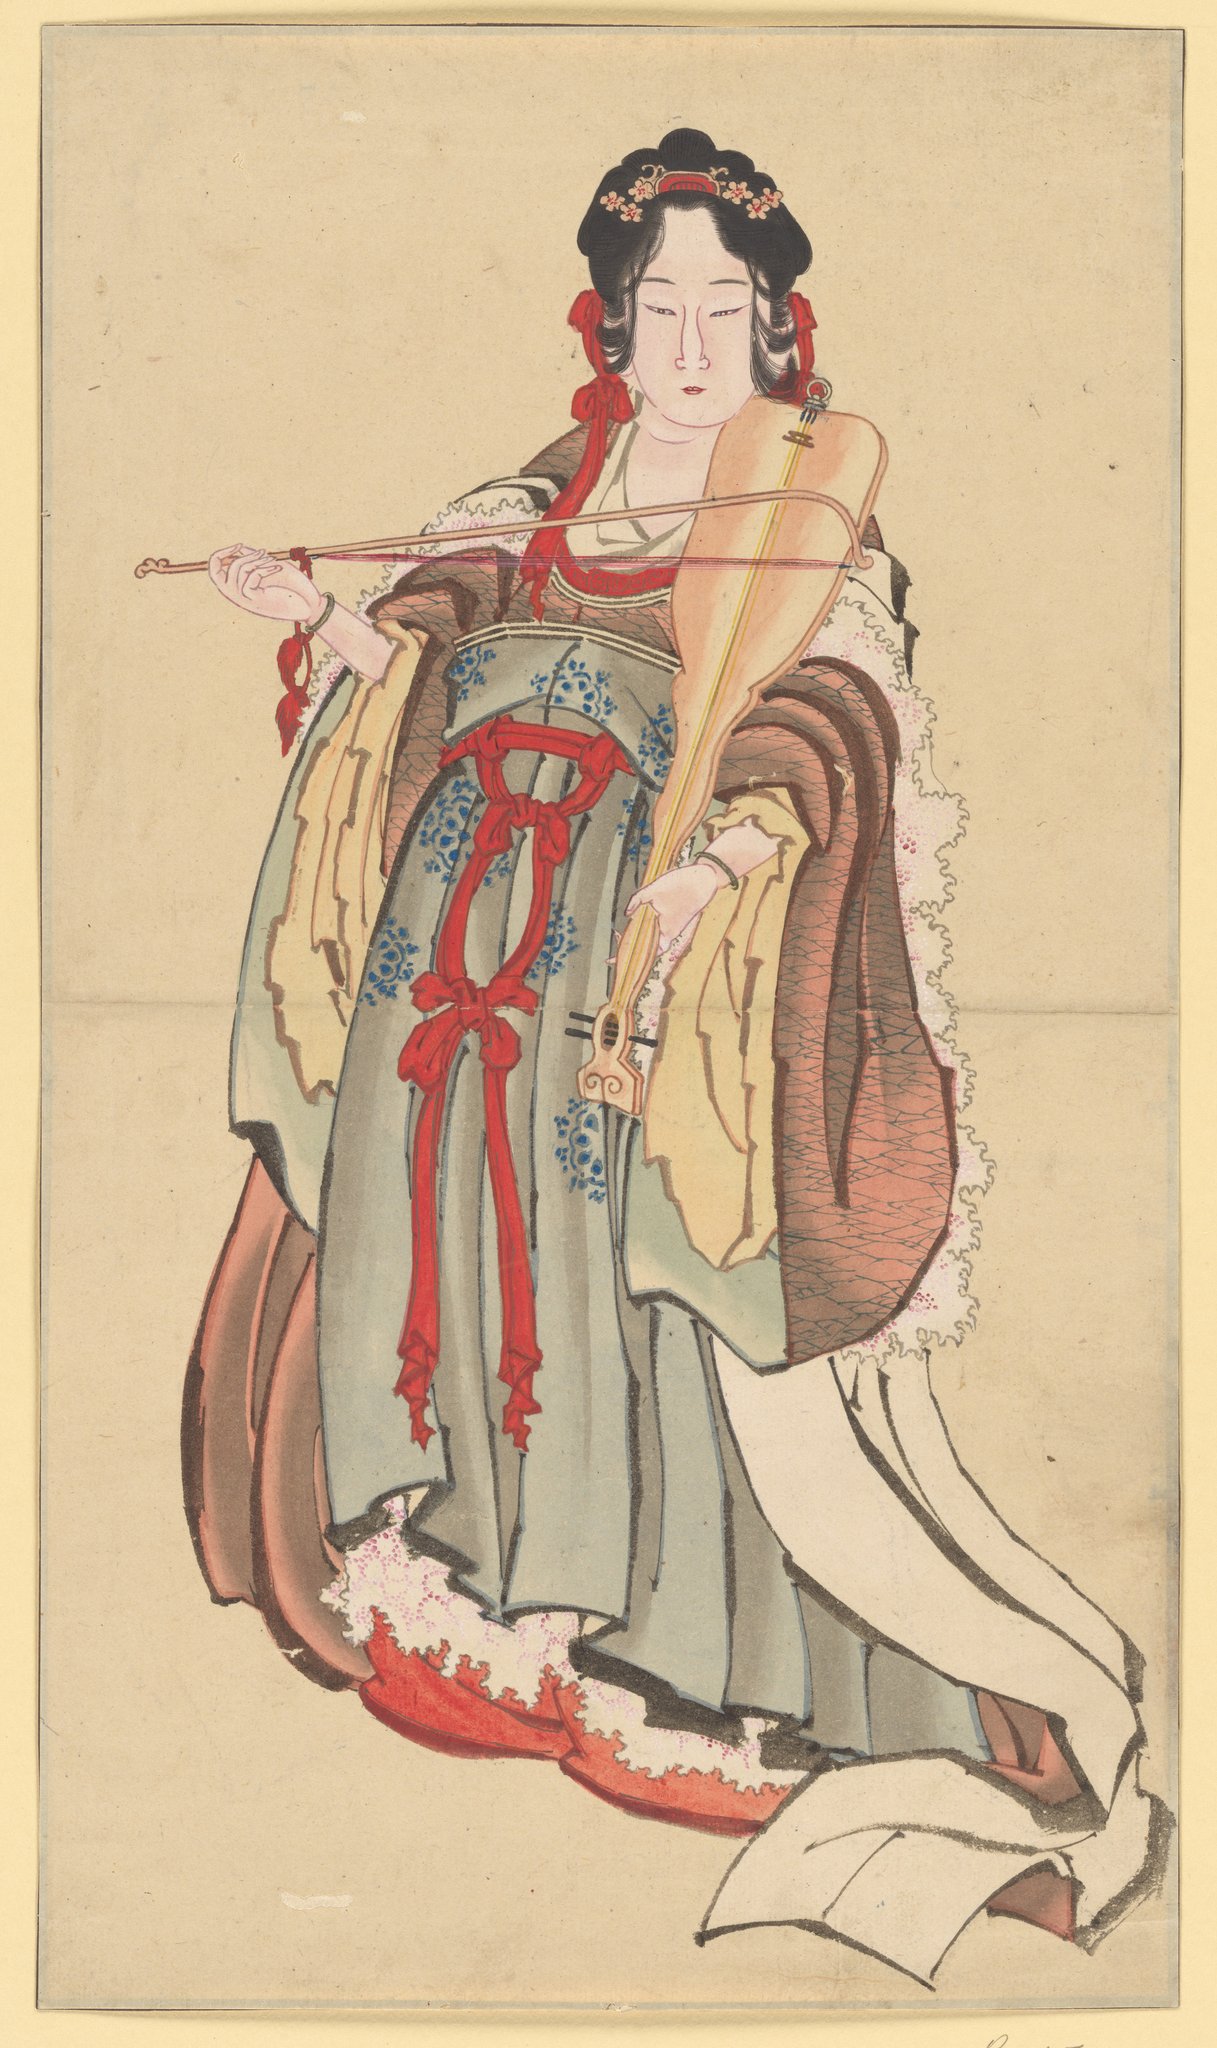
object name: drawing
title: Benten (Goddess of Love)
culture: japanese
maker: katsushika hokusai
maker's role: artist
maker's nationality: japanese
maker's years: 1760-1849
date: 1701-1900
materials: ink, paper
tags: musical instruments,goddess